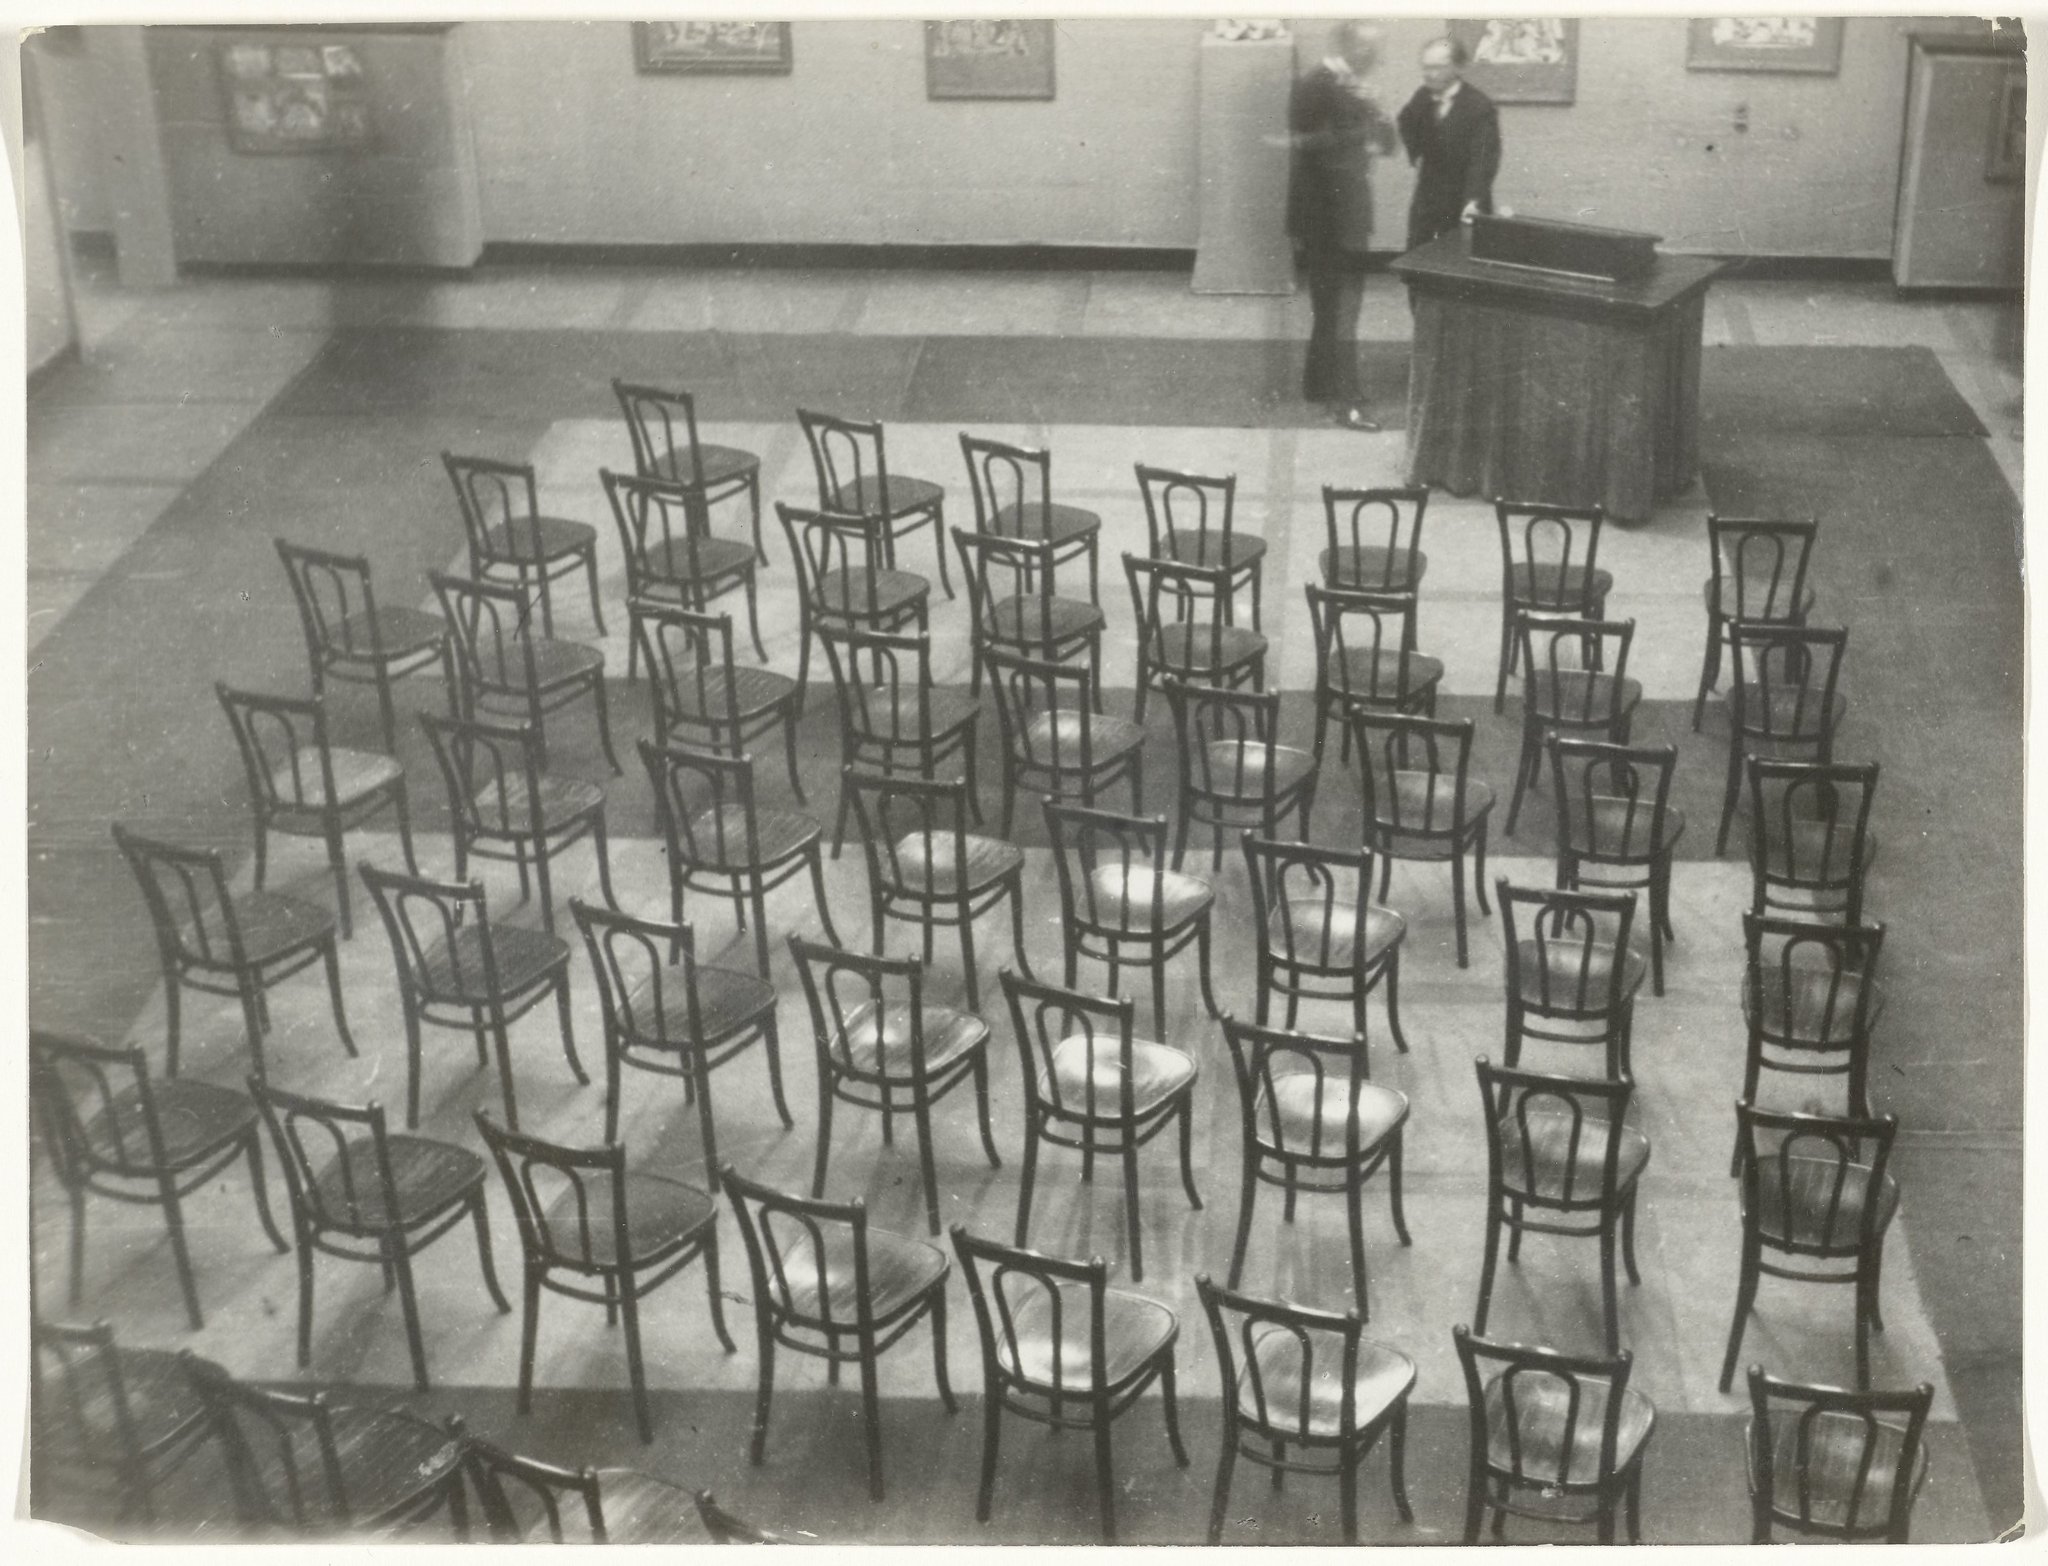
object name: photograph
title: Karl With en Konrad Adenauer voor een lege zaal met stoelen, mogelijk Museum für Kunstgewerbe in Keulen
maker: hannes flach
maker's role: fotograaf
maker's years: 1901-1936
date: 1925-1933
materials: paper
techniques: gelatin silver print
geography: cologne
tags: cologne, politician, karl with, address, talk, lecture (~ meeting), chair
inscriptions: stamp: ‘Hannes Flach/ Köln-Zollstock/ Kanalstrasse 110/ Ruf 92584’, inscription: ‘Karl With/ +/ Adenauer’